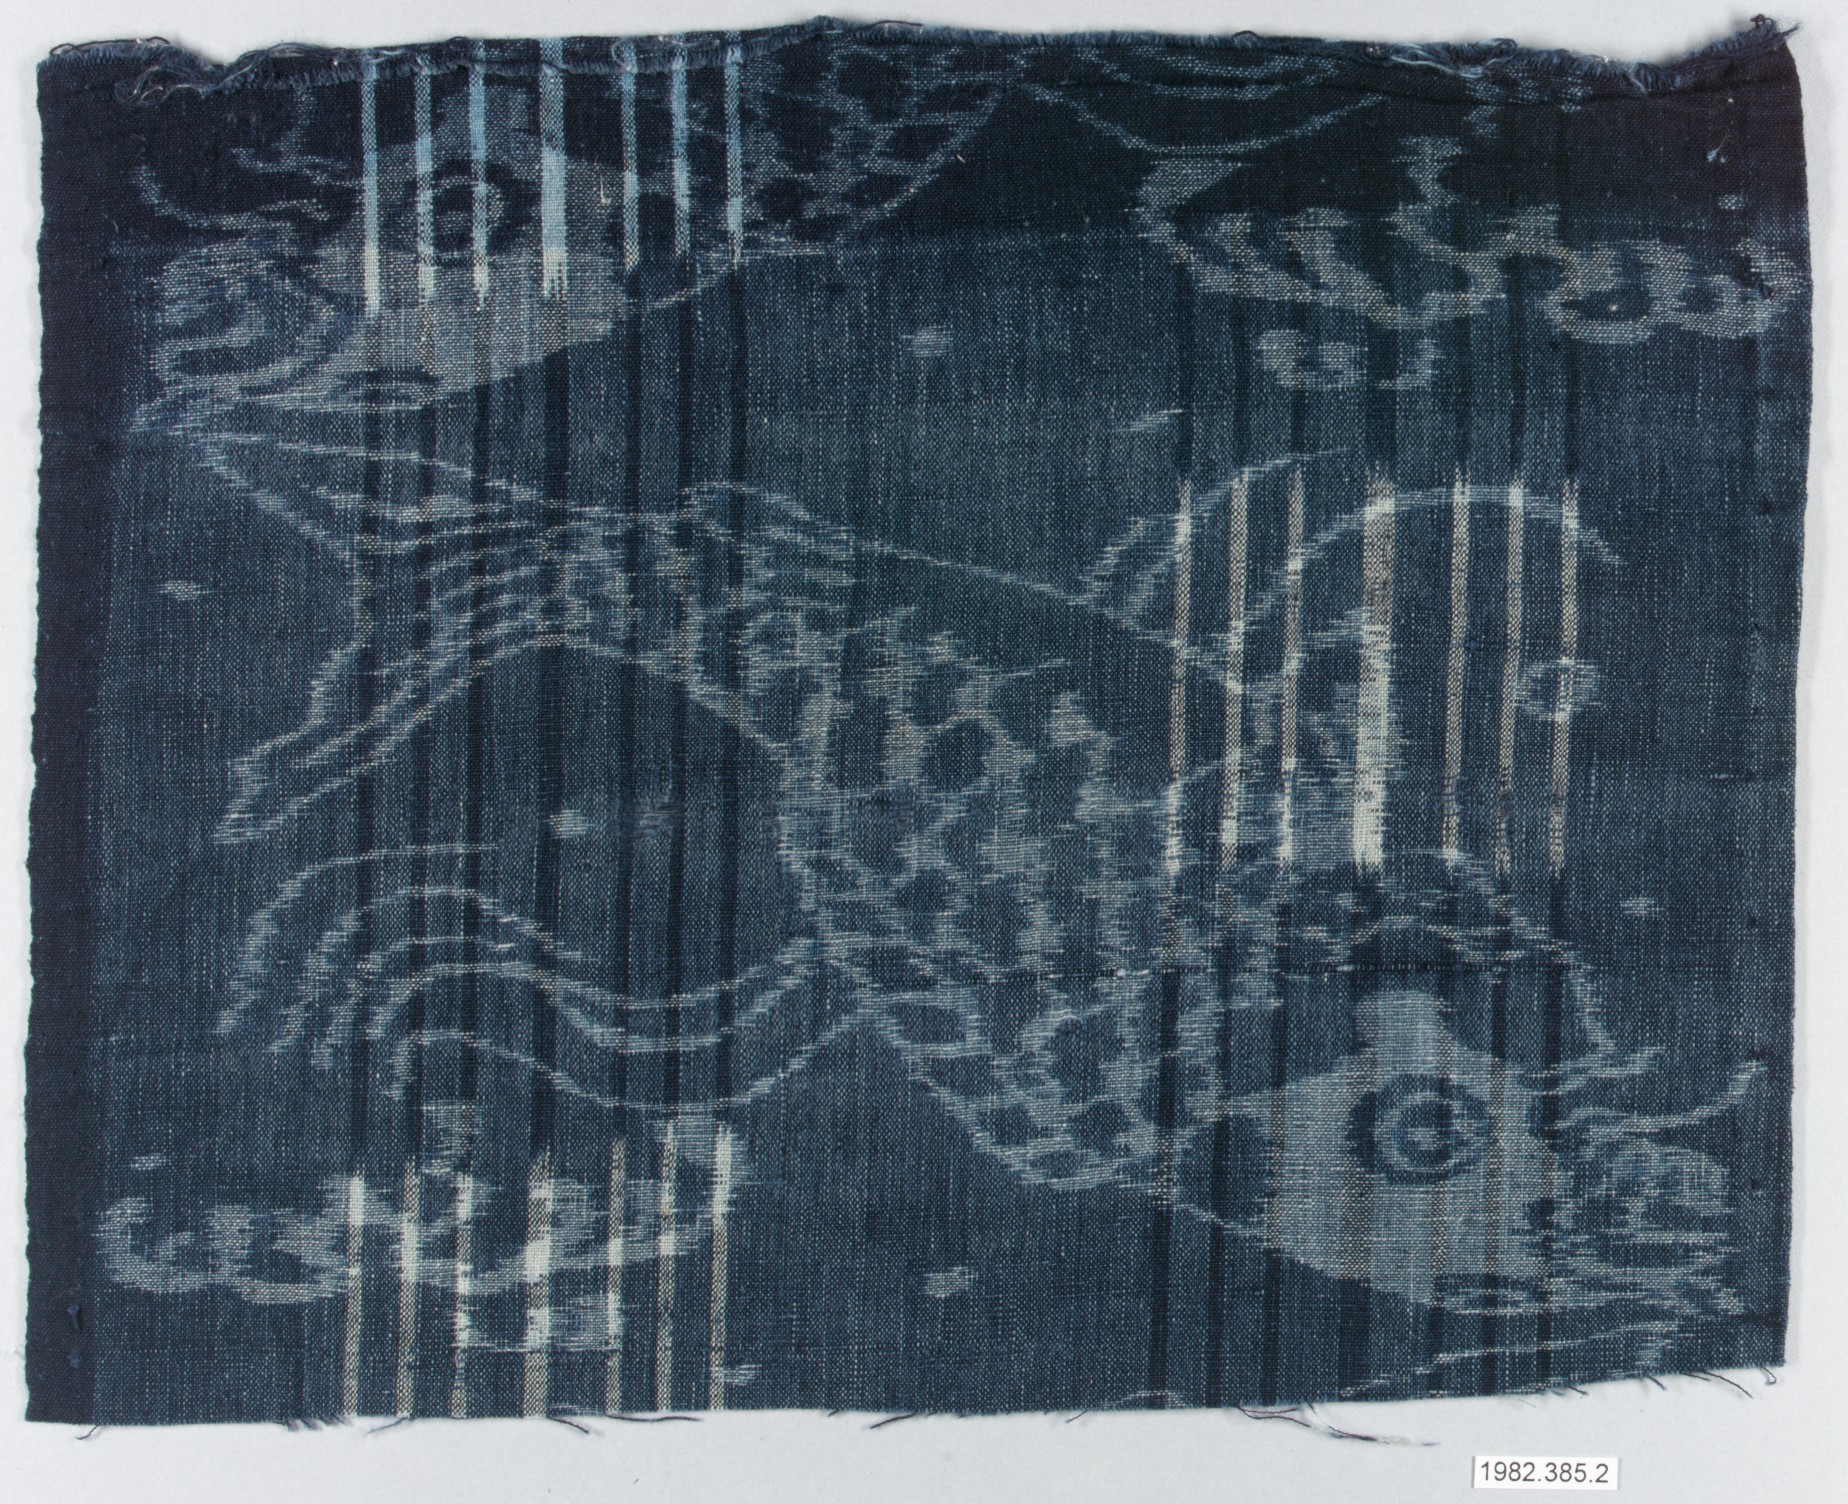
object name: piece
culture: japanese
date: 1868-1926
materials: cotton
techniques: dyeing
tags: fish